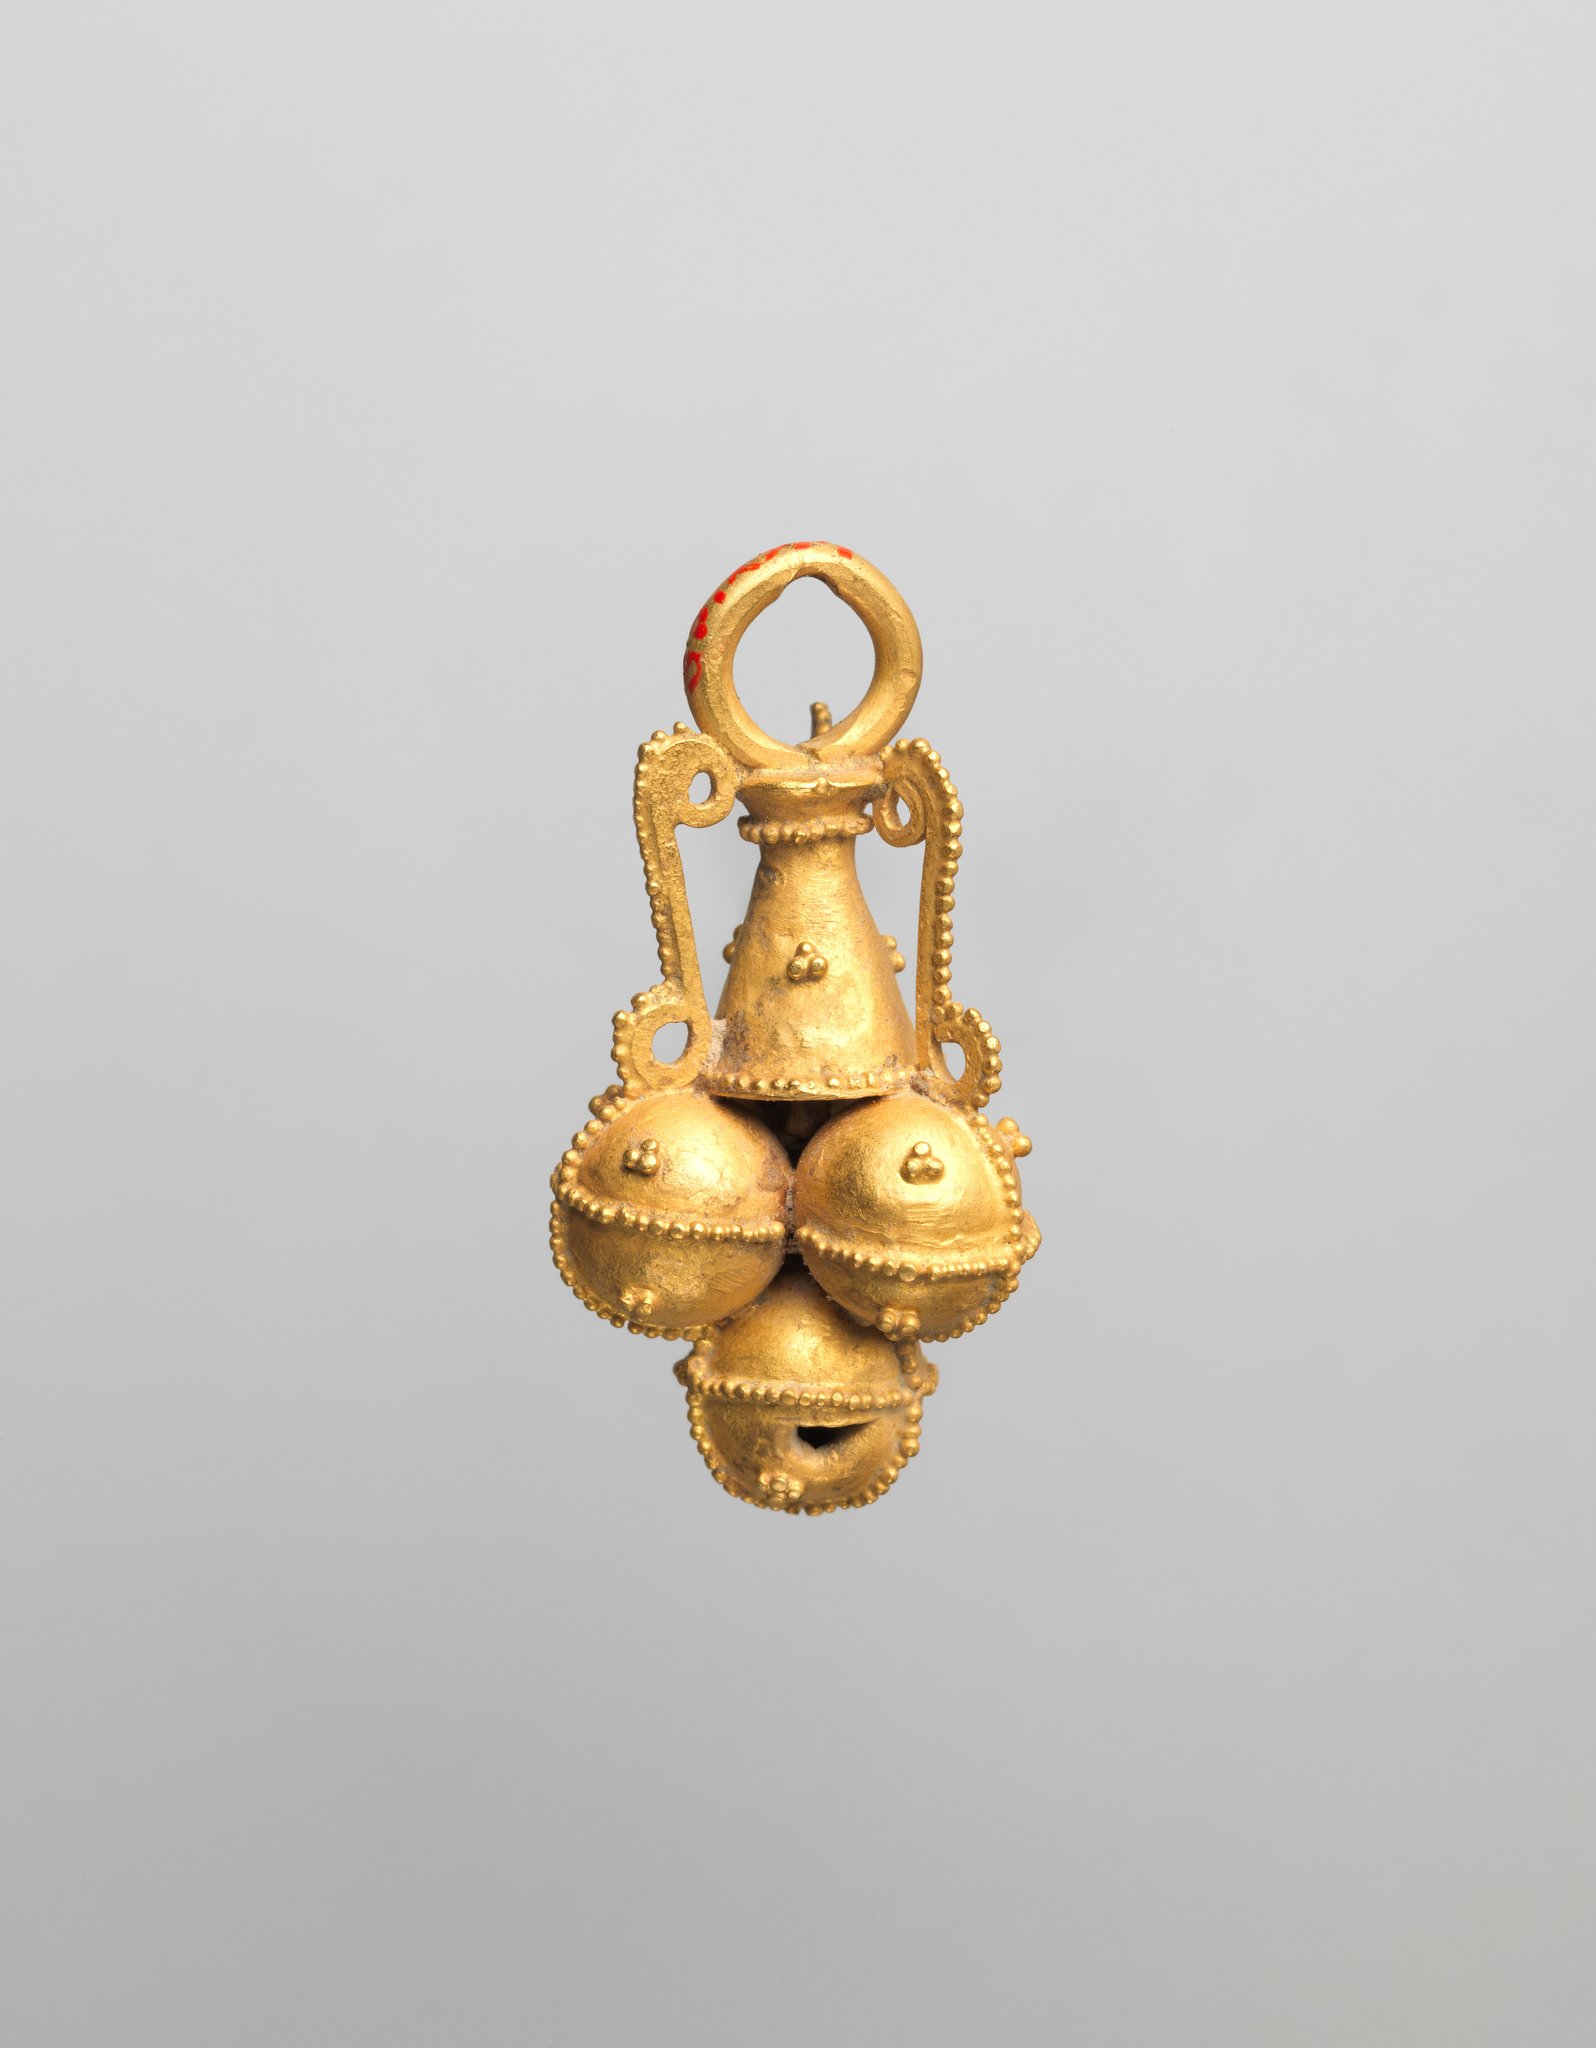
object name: earring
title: Earrings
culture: parthian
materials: gold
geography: mesopotamia